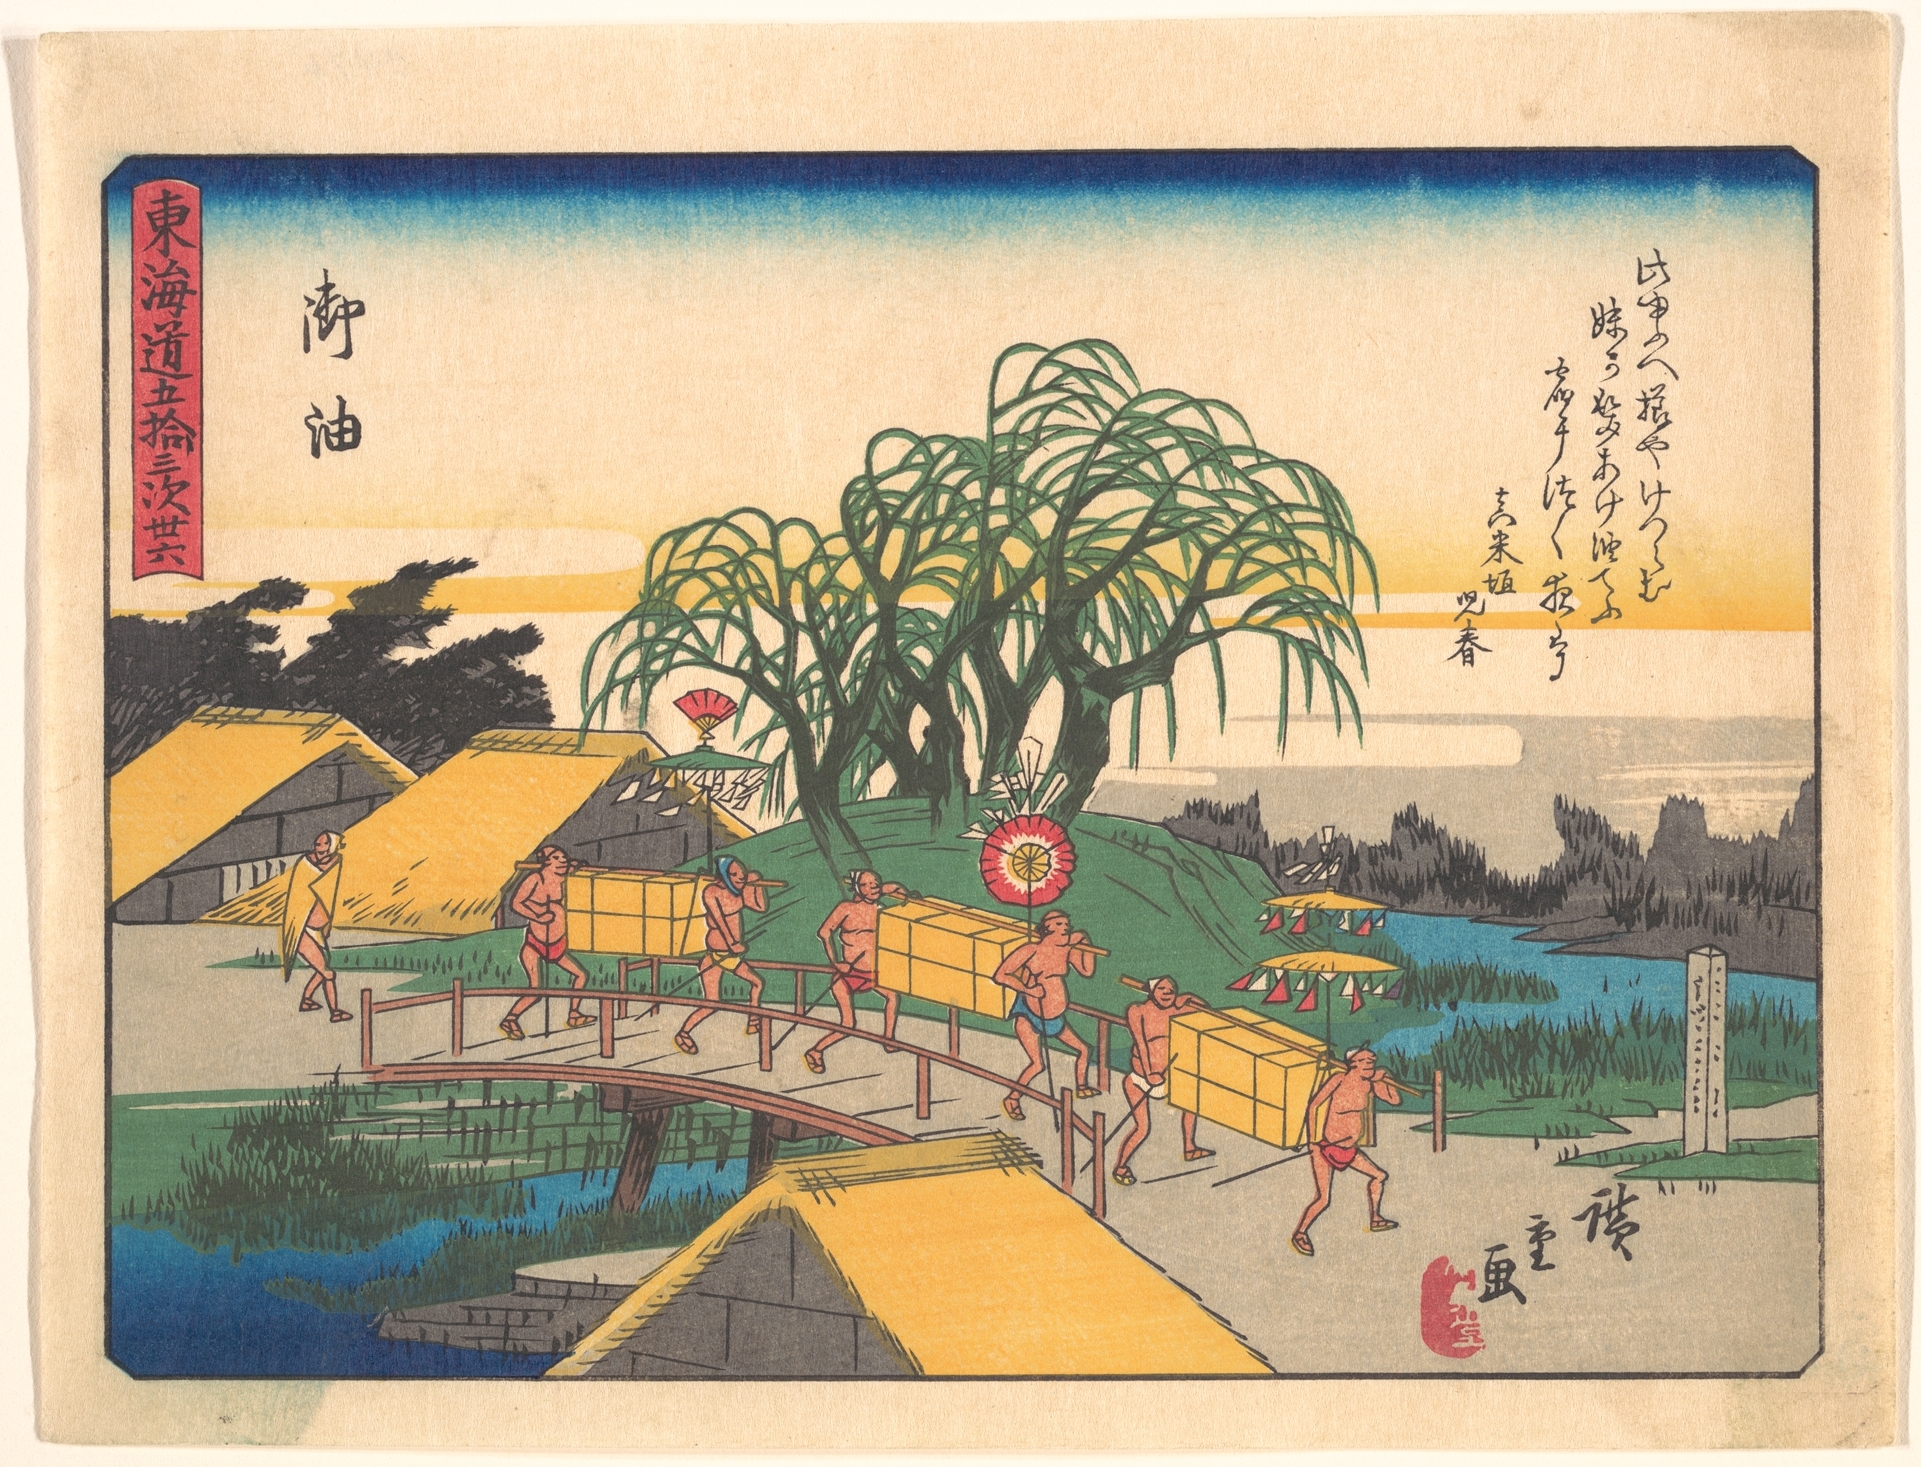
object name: print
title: Goyu, from the series The Fifty-three Stations of the Tōkaidō Road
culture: japanese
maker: utagawa hiroshige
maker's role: artist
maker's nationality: japanese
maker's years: 1797-1858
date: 1901-1933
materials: ink, paper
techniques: woodblock print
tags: houses,bridges,men,trees